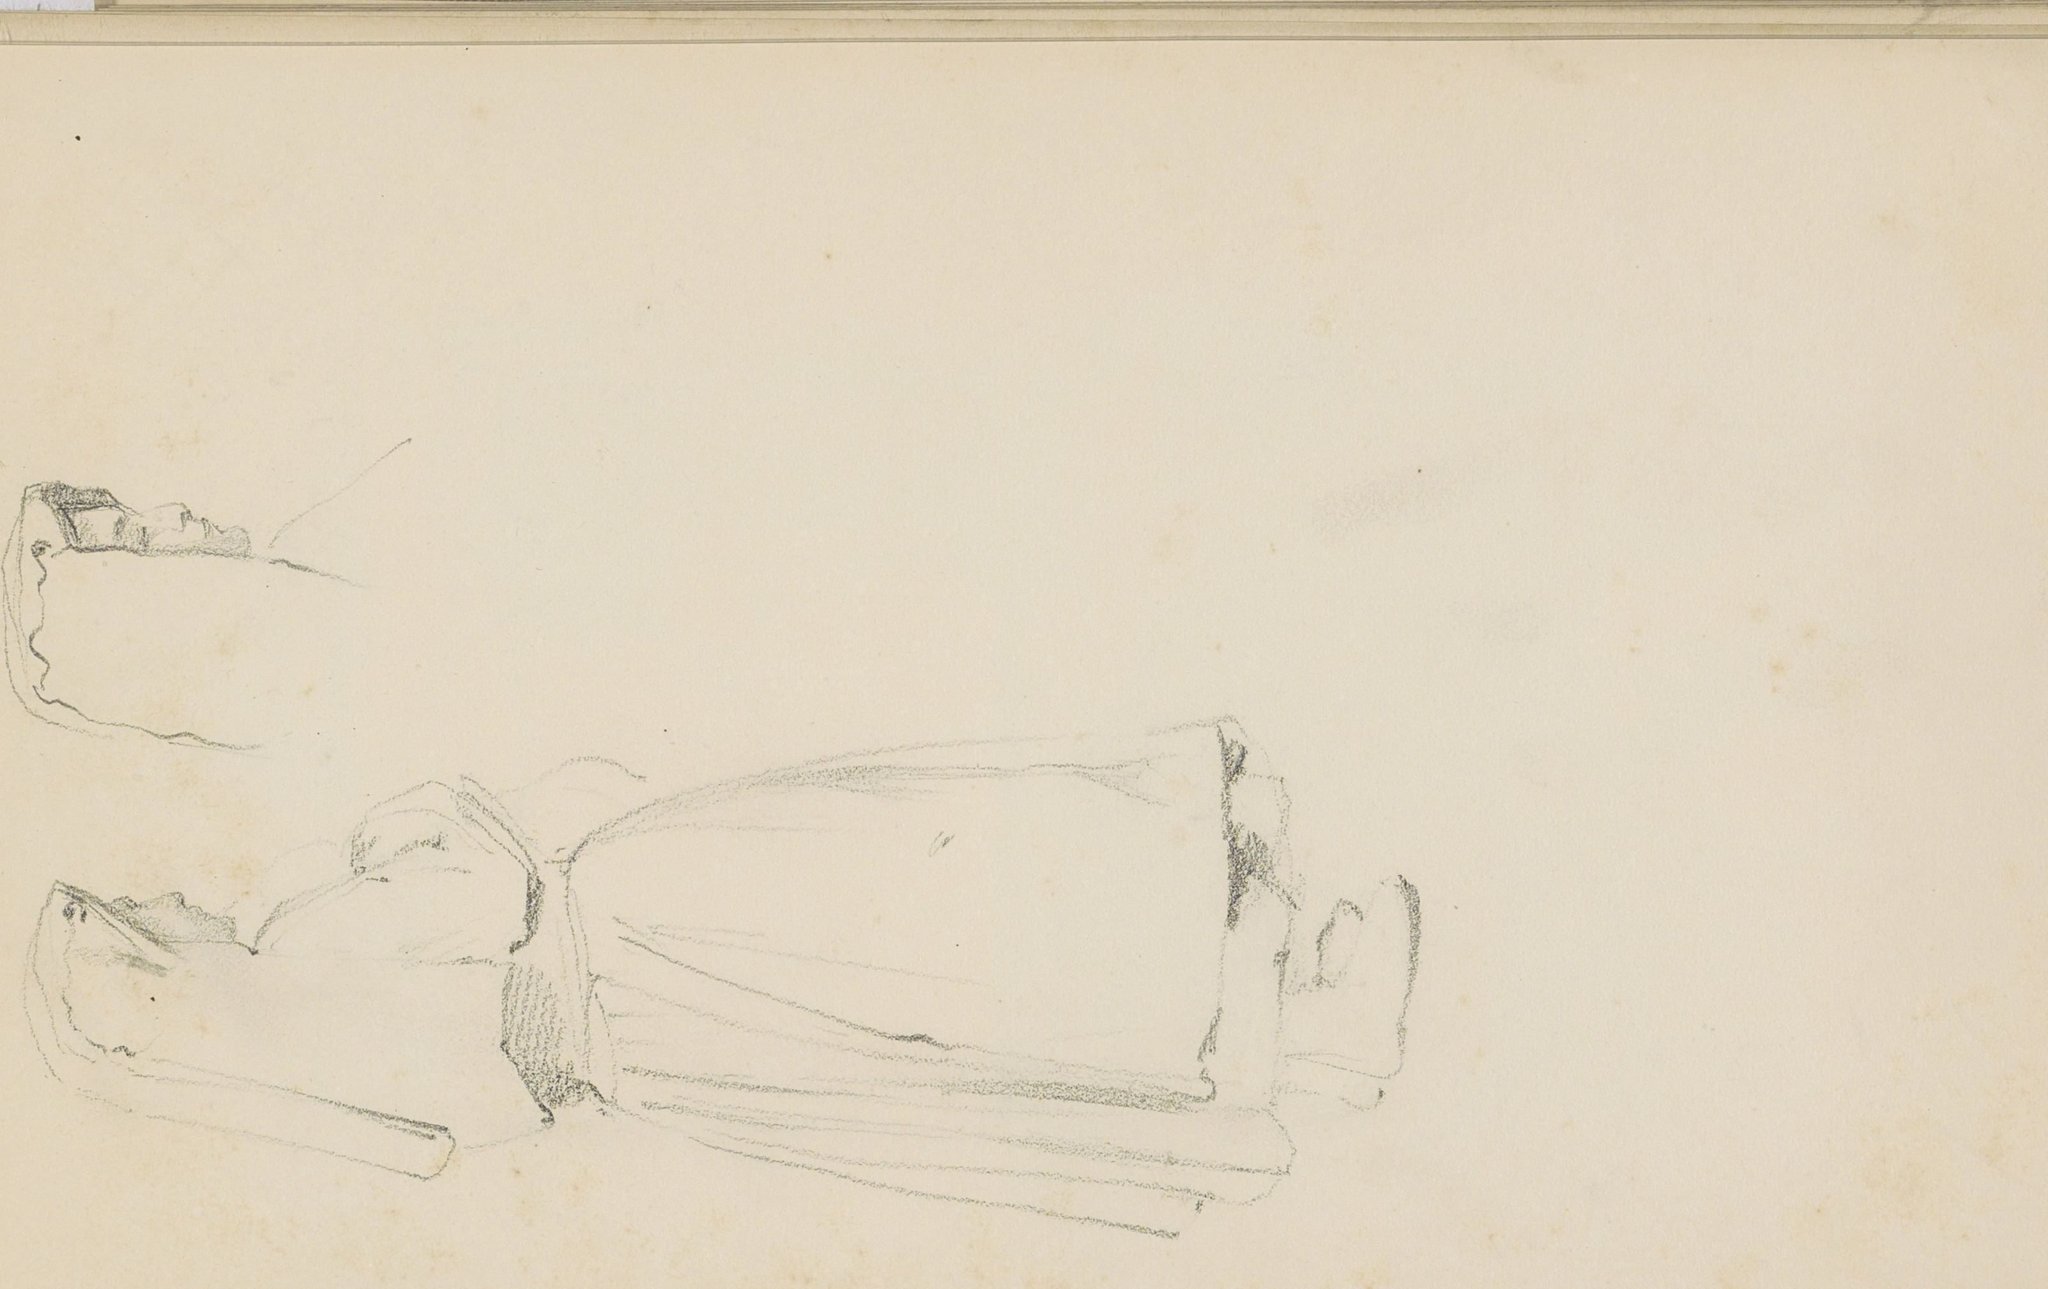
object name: sketchbook leaf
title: Staande vrouw met een hoofddoek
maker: a.a.l. de grammont-hubrecht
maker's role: draughtsman, painter, print maker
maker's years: 1855-1913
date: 1865-1913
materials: paper, pencil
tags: head (human), adult woman, head-gear: cap (+ men's clothes)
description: Tevens een studie van het gezicht van de vrouw in profiel naar rechts. Blad 37 recto uit een schetsboek met 65 bladen.